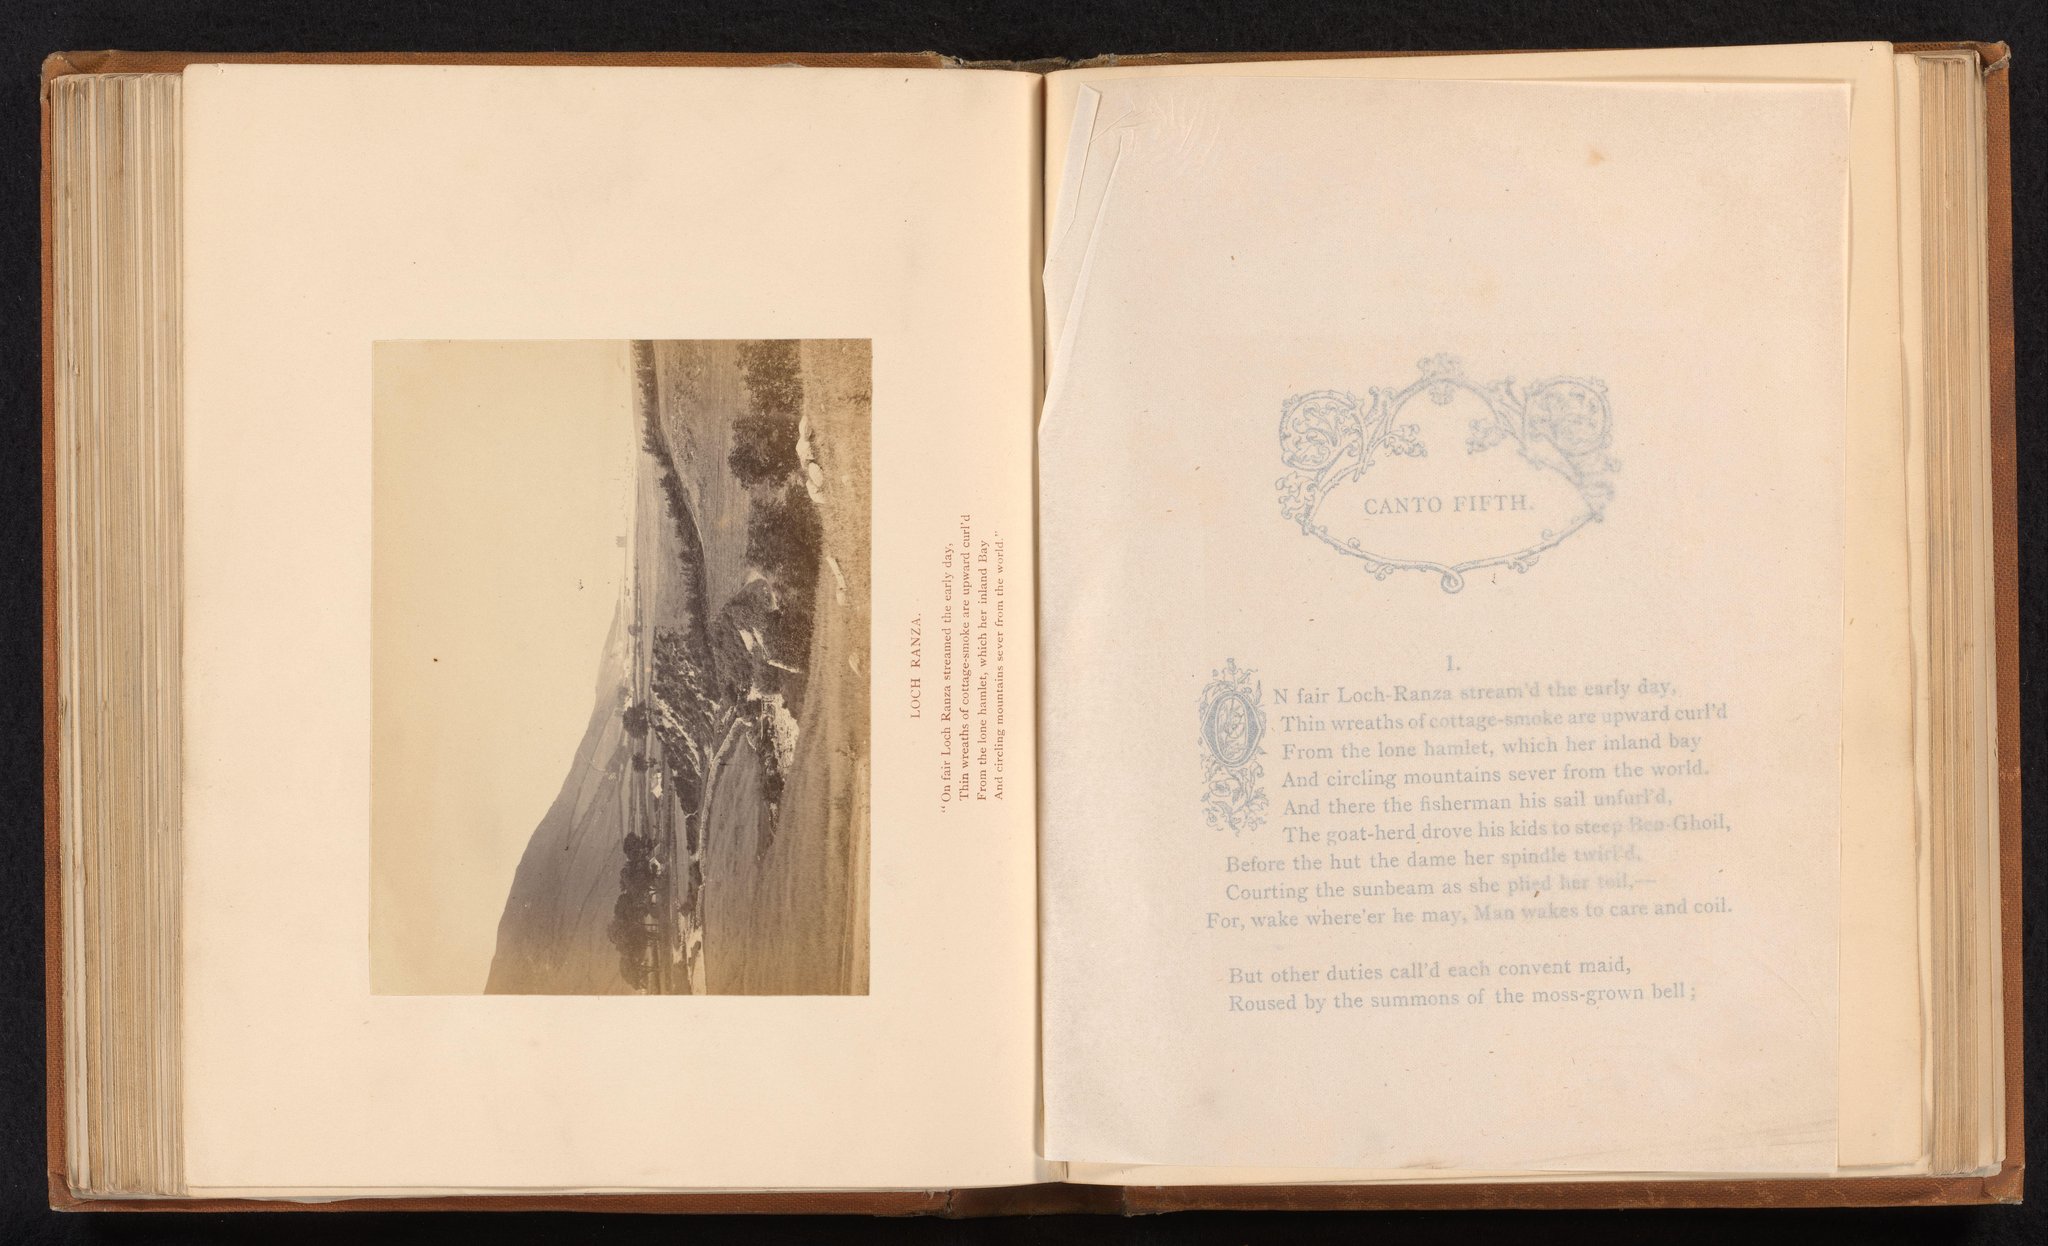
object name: photograph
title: Lochranza op Arran in het westen van Schotland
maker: william russell sedgfield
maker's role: fotograaf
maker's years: 1826-1902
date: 1861-1871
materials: paper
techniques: albumen print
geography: arran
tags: island, landscapes, lake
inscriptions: inscription: ‘"On fair (...) the world."’